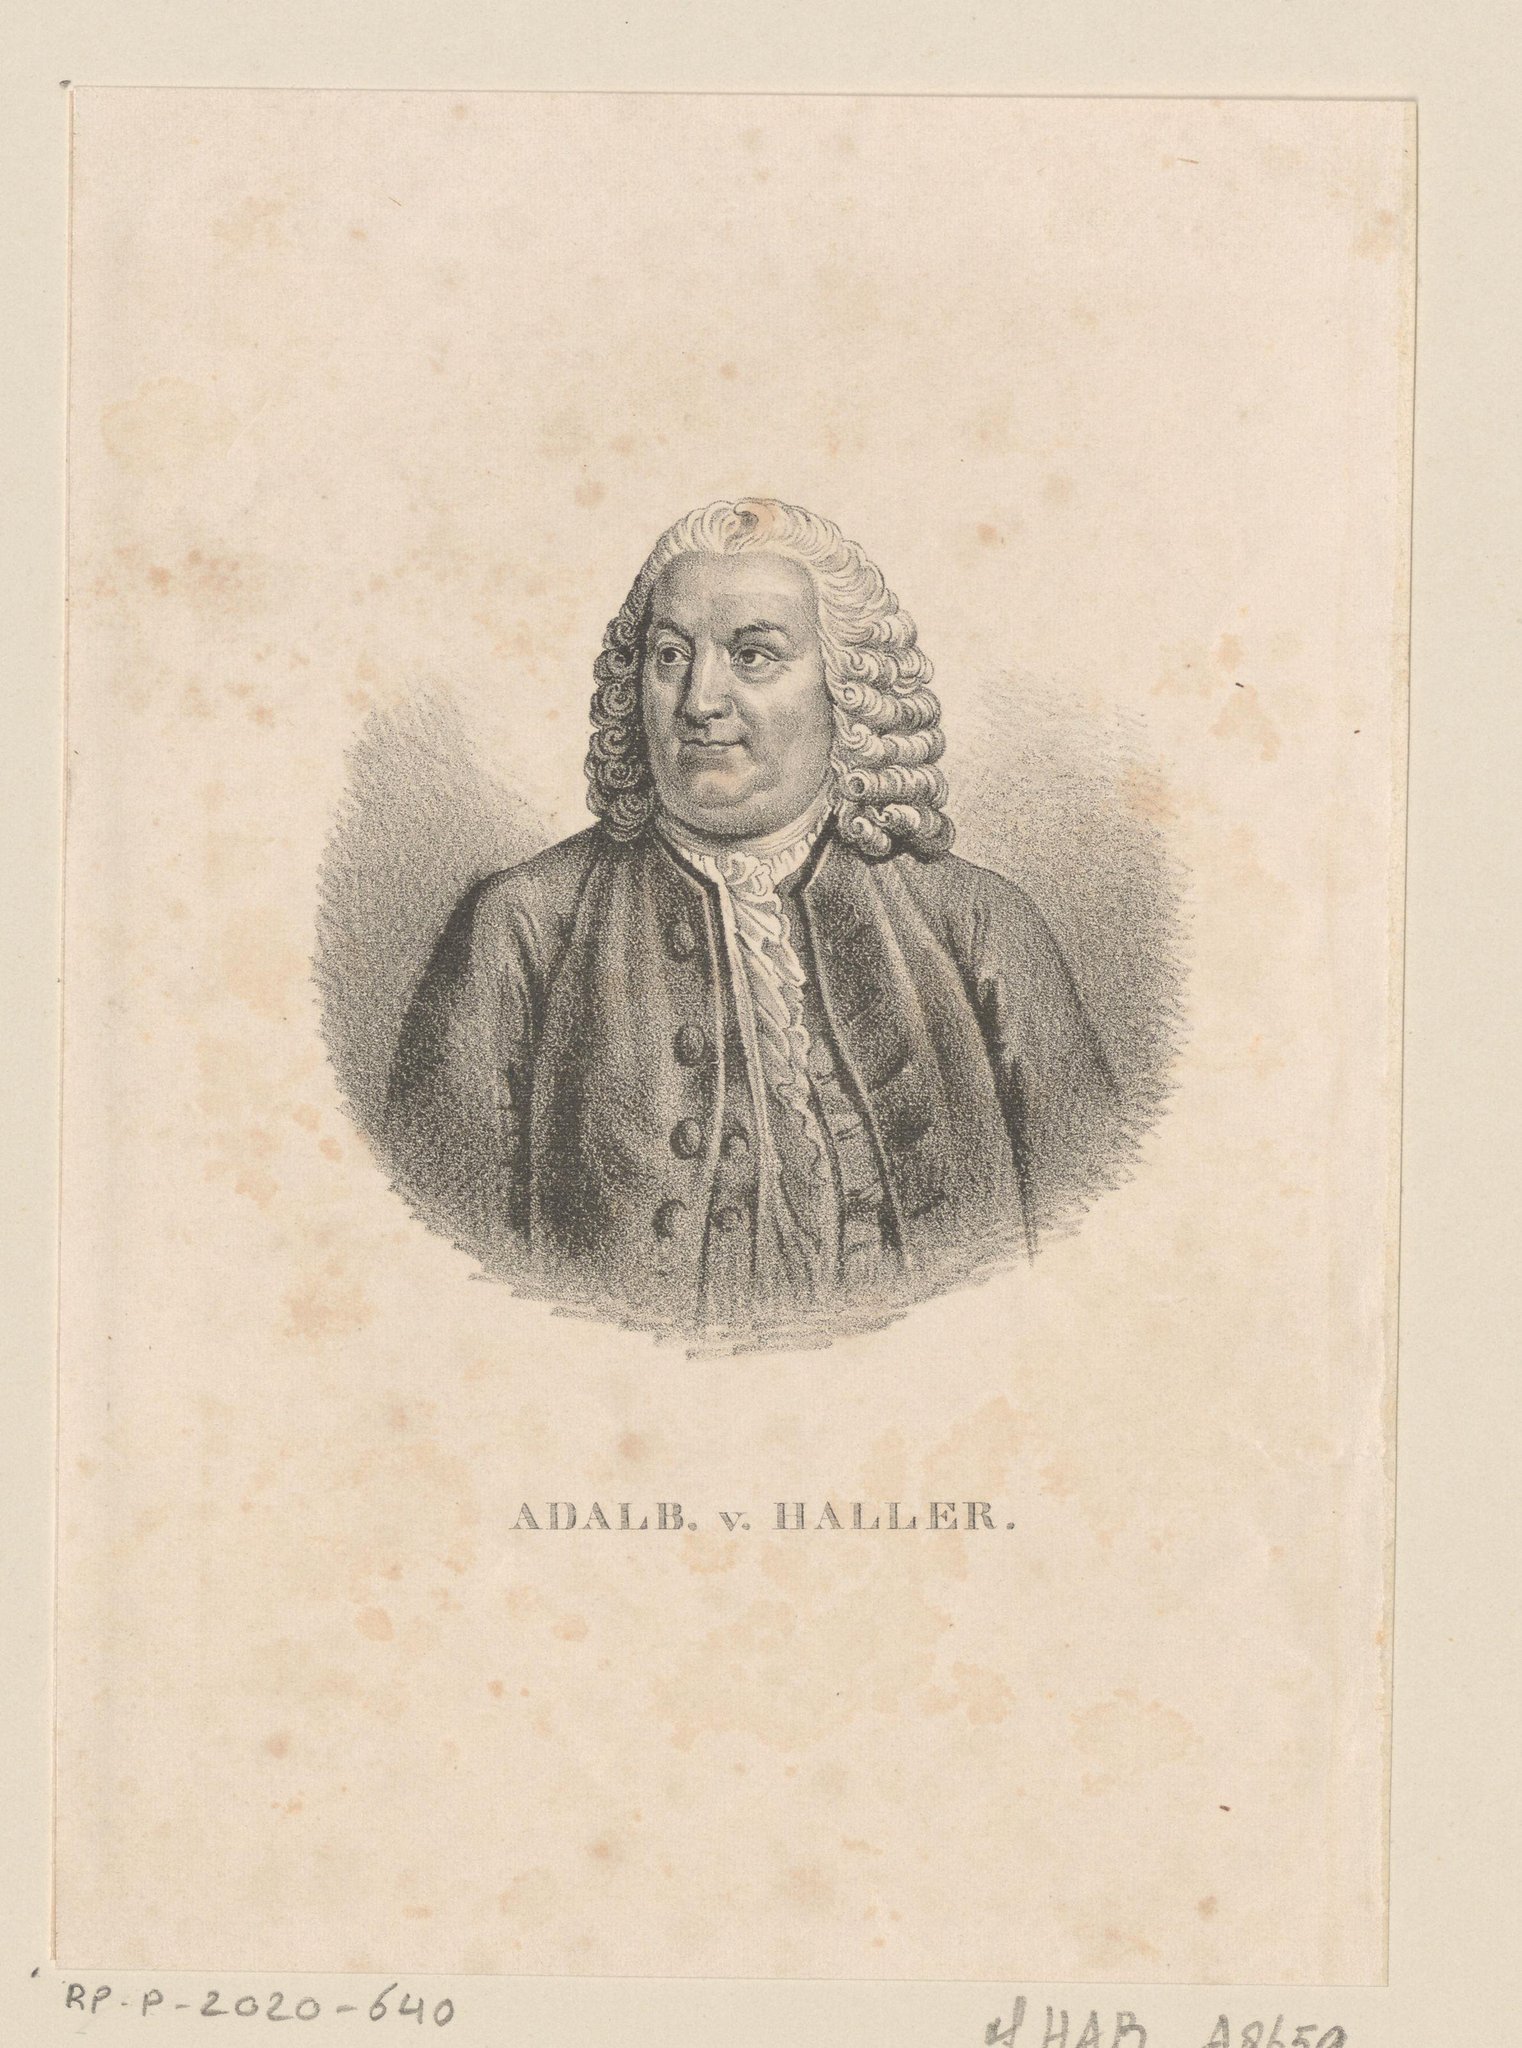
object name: print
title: Portret van Albrecht von Haller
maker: Anonymous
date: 1825-1874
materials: paper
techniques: lithograph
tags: historical persons, physician, doctor, writer, poet, author